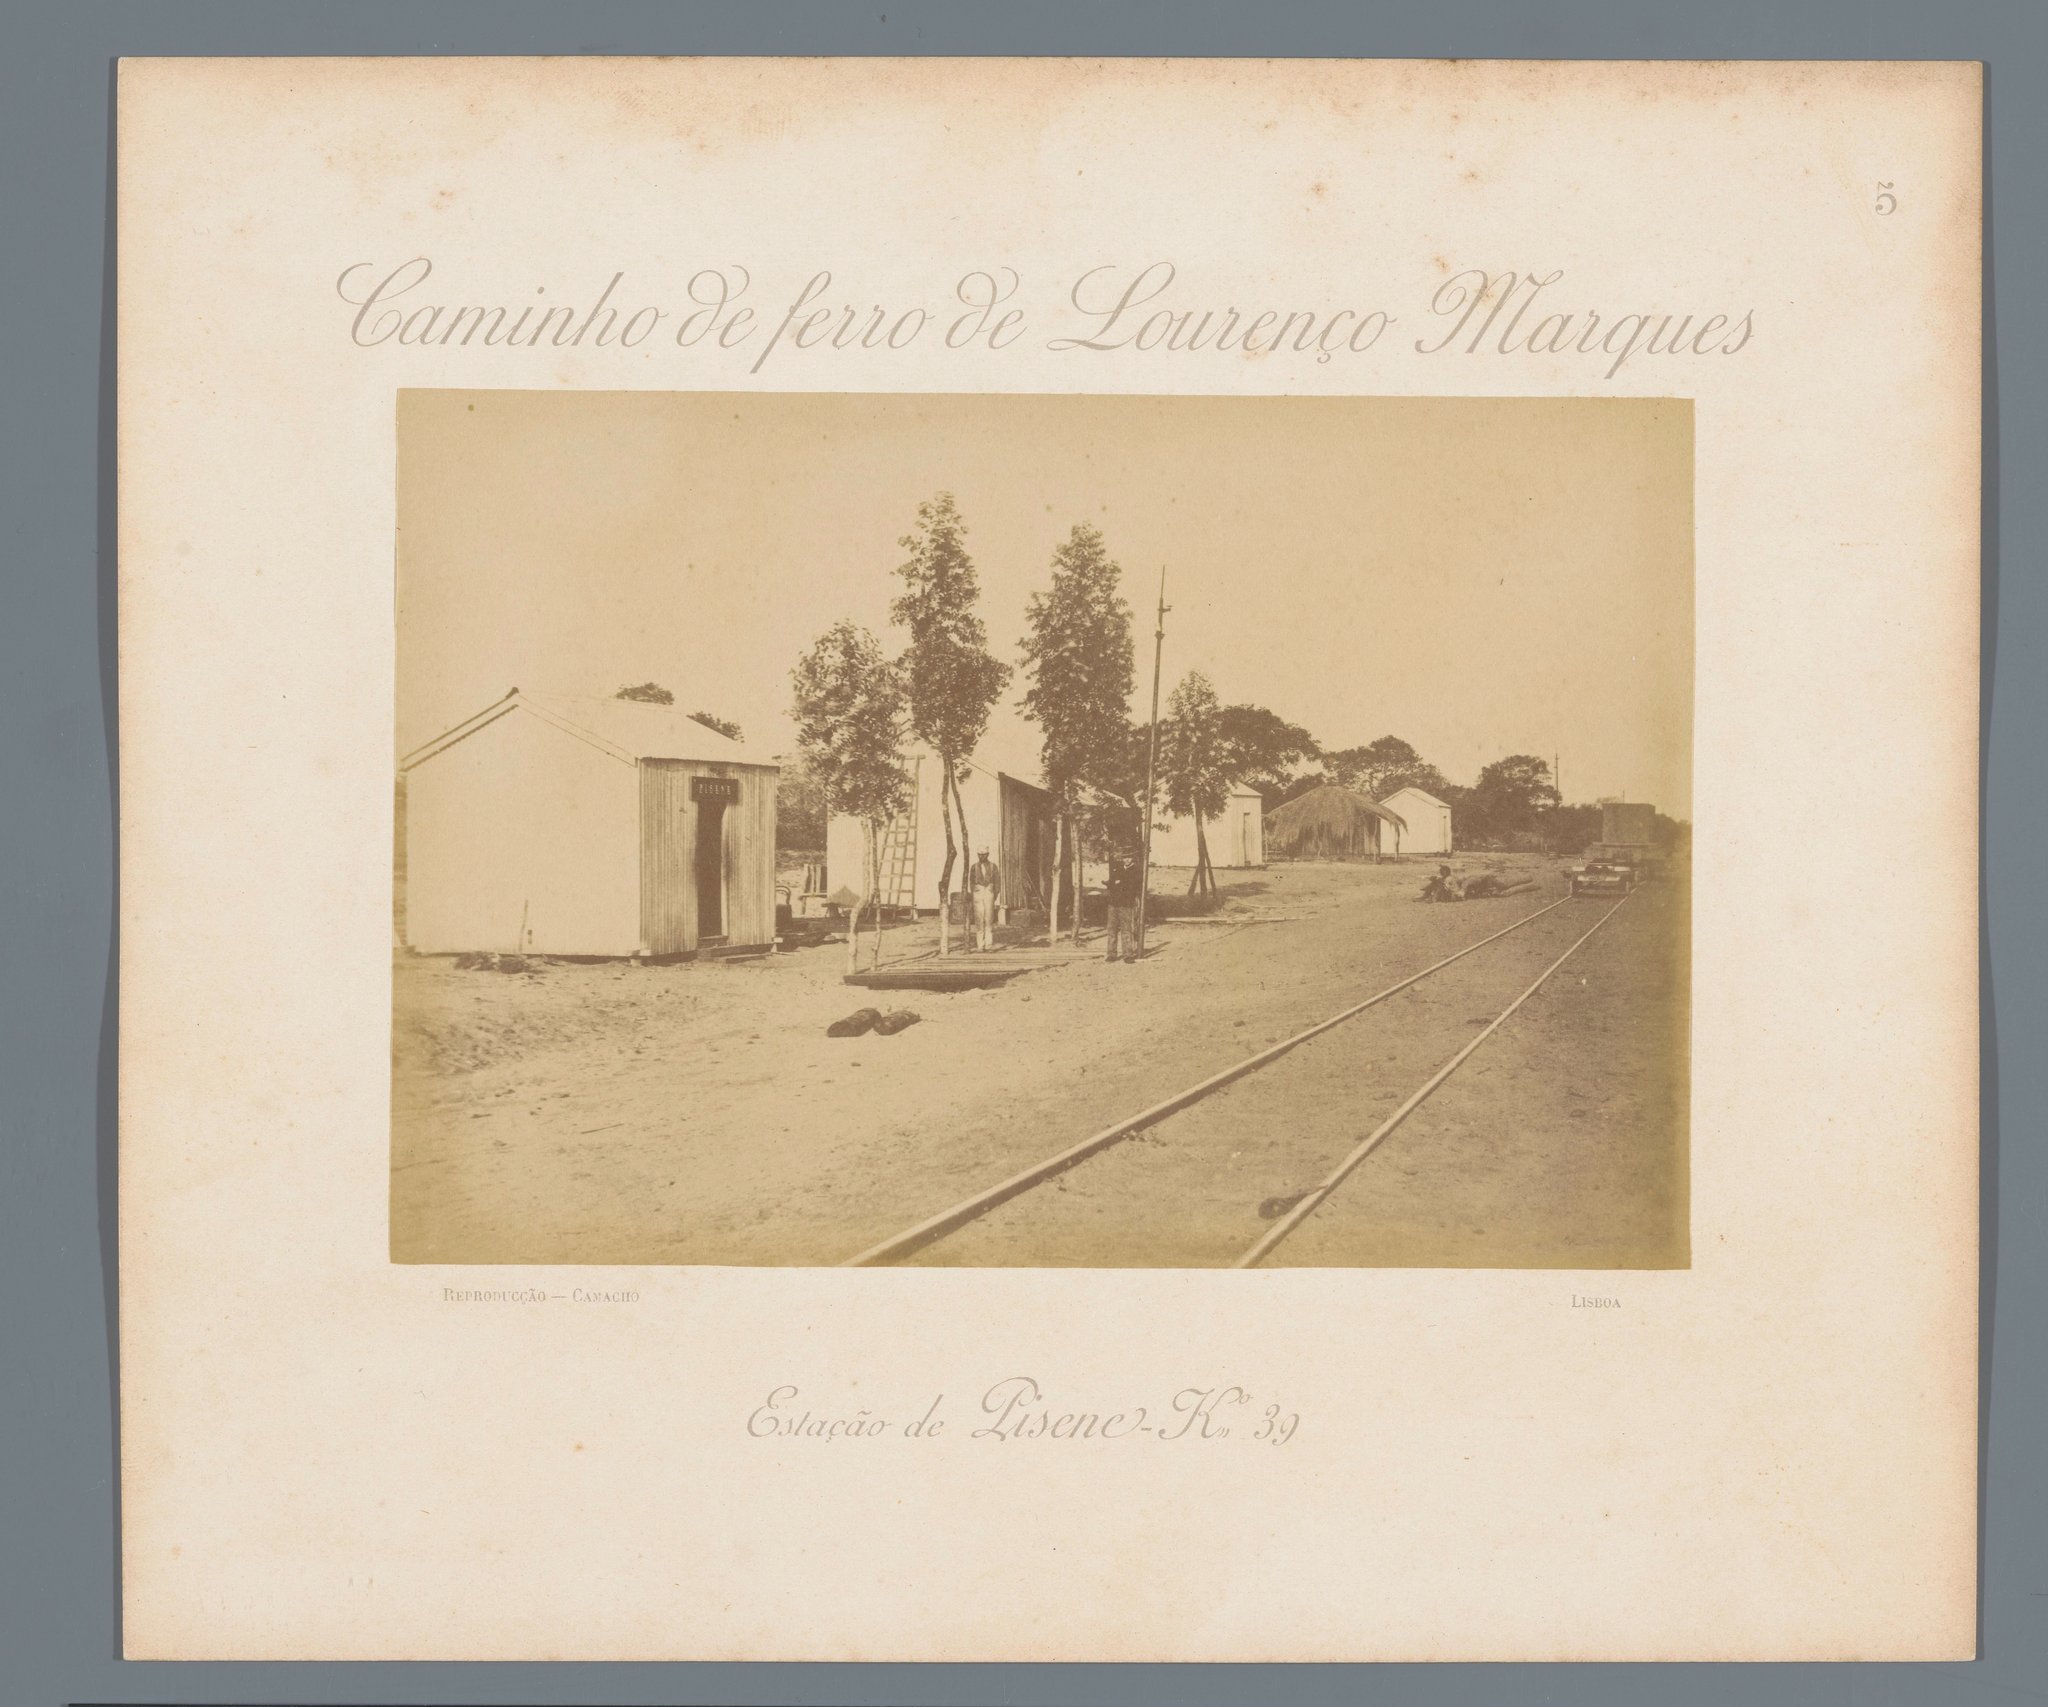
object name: photograph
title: Caminho de ferro de Lourenço Marques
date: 1886-1895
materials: photographic support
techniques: albumen print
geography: lisbon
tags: railway, train, station; shelter (railway, tramway)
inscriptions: number: ‘5’